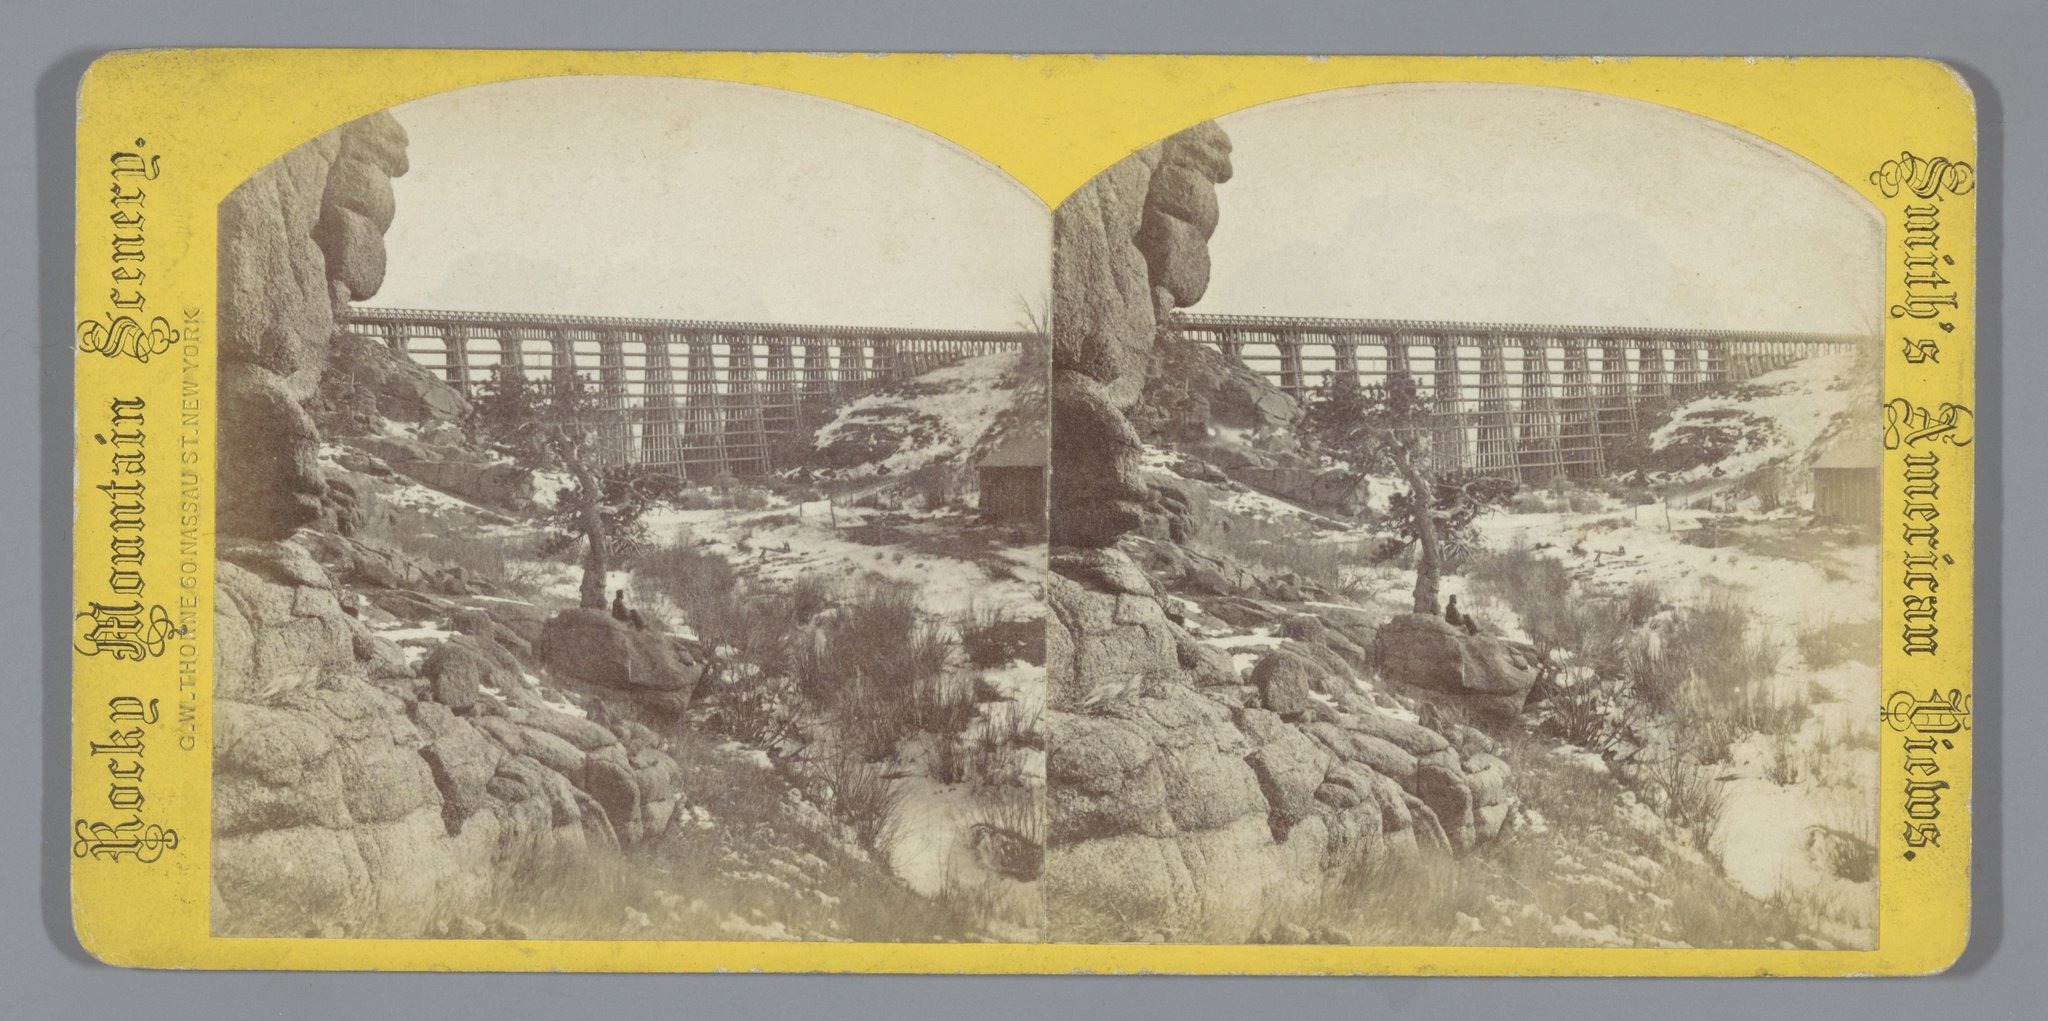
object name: stereograph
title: Rocky Mountain Scenery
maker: george w. thorne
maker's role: publisher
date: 1876-1880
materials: cardboard, paper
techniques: albumen print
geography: wyoming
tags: bridge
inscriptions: inscription: ‘Union Pacific/ R. R./ Stereoscopic Views,/ Across the Continent West from Omaha.’, inscription: ‘Bitter Creek Series, Continued./ 173. - Cut near Green River/ 174. - Cut Horses at Work, Green River/ 175. - Giant's Club, Green River (...)’, title: ‘Dale Creek Bridge’, number: ‘5’